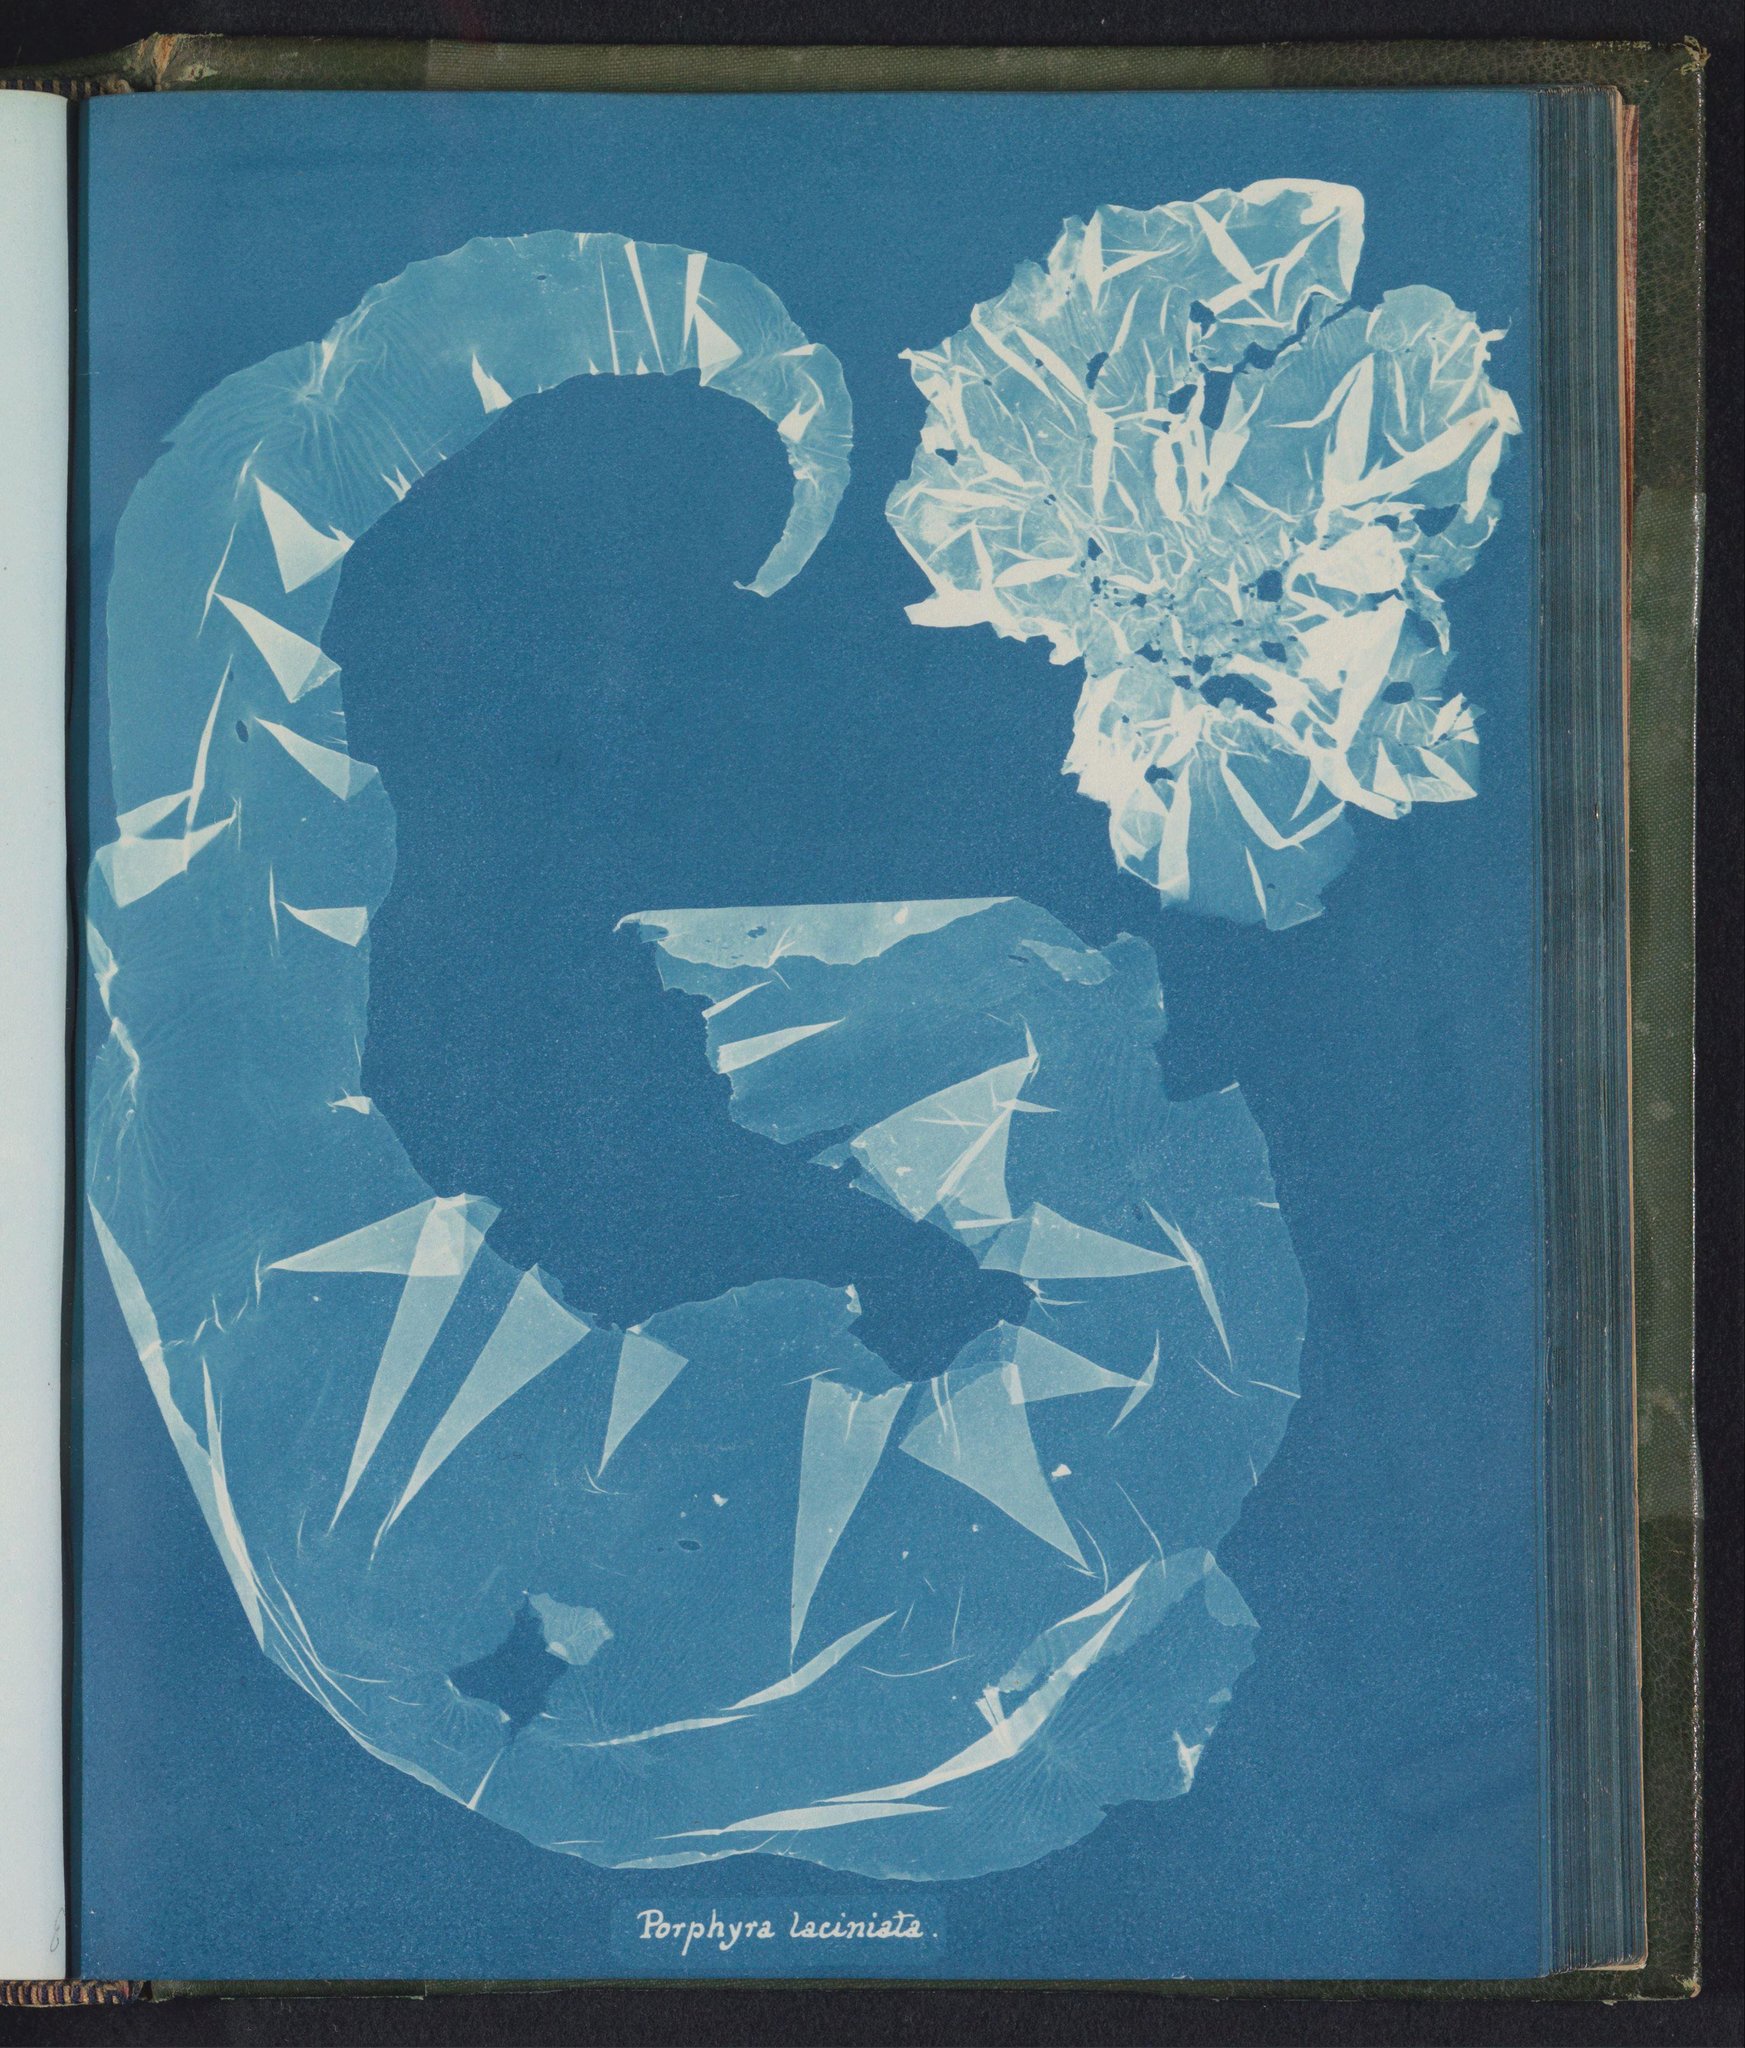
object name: page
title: Porphyra laciniata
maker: anna atkins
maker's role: fotograaf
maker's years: 1799-1871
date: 1843-1853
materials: photographic support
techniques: cyanotype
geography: united kingdom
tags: algae, seaweed